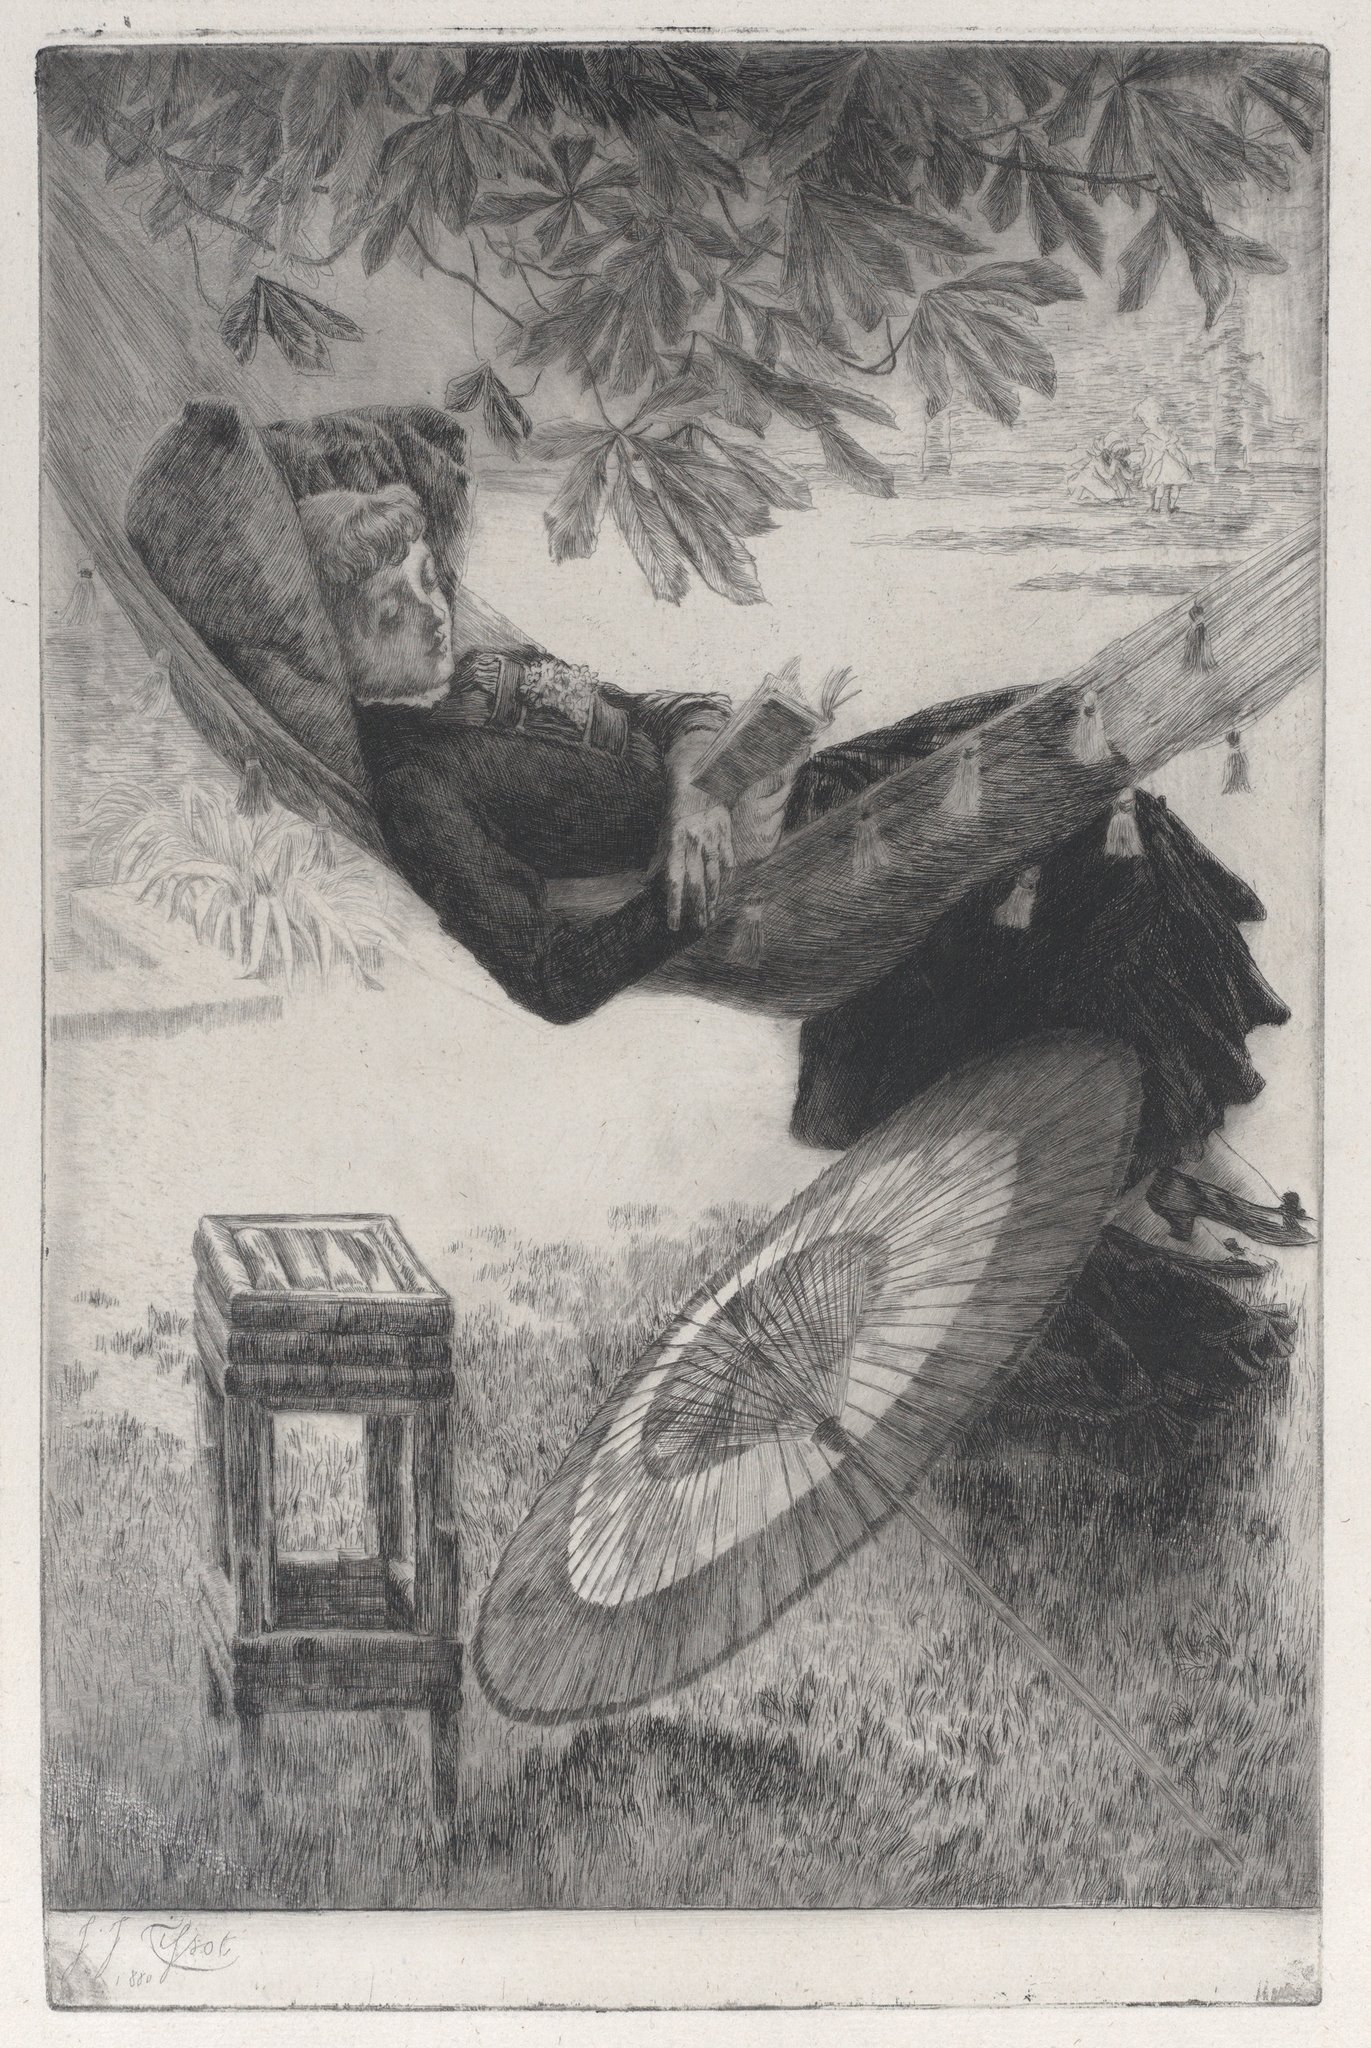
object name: print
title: The Hammock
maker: james tissot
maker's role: artist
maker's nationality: french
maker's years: 1836-1902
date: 1880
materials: paper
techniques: drypoint, etching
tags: women,reading,parasols